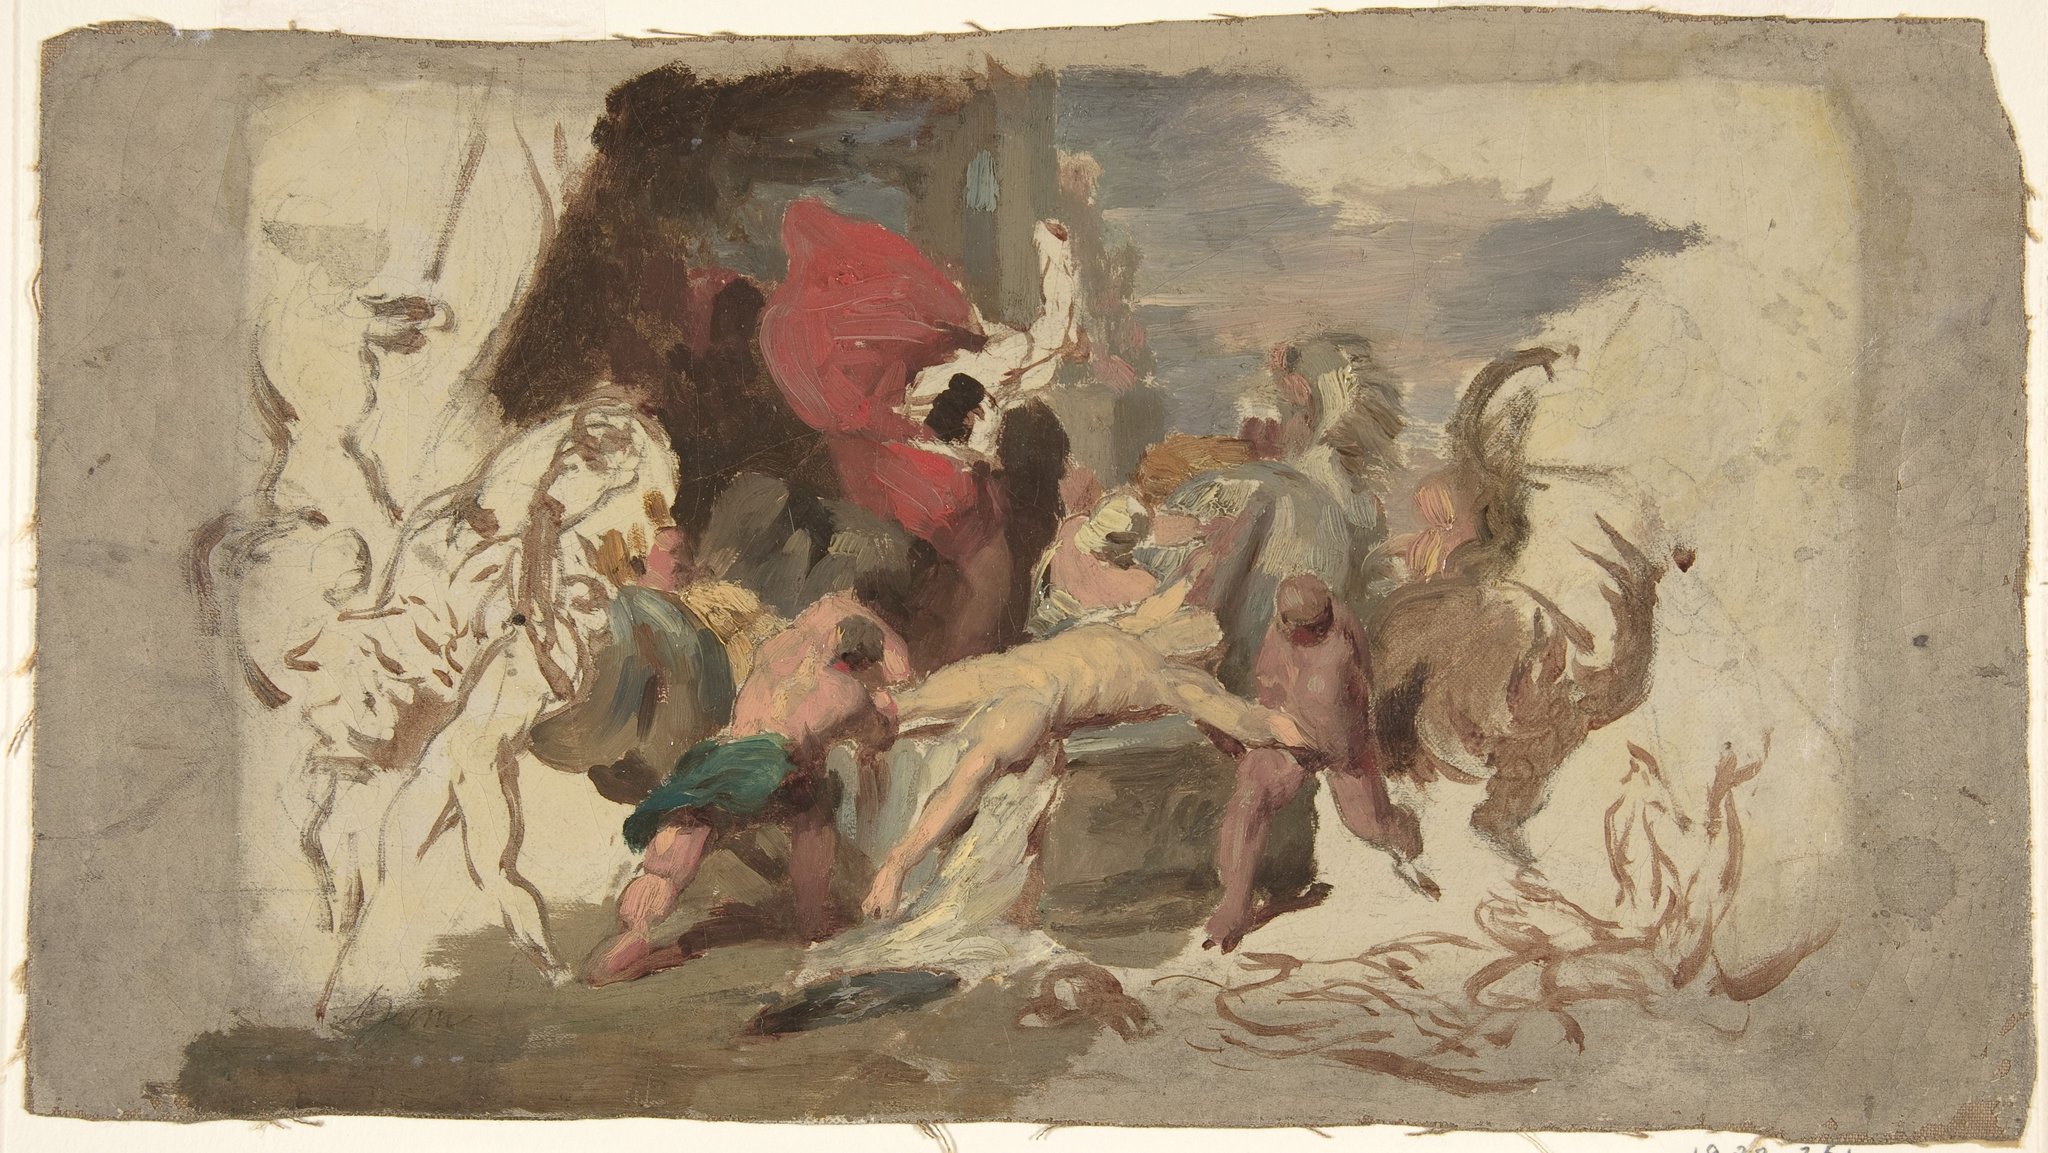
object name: drawing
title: The Martyrdom of Saint Hippolytus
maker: françois joseph heim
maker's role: artist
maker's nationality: french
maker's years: 1787-1865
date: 1801-1900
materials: canvas, chalk, oil, varnish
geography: france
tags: men,saints